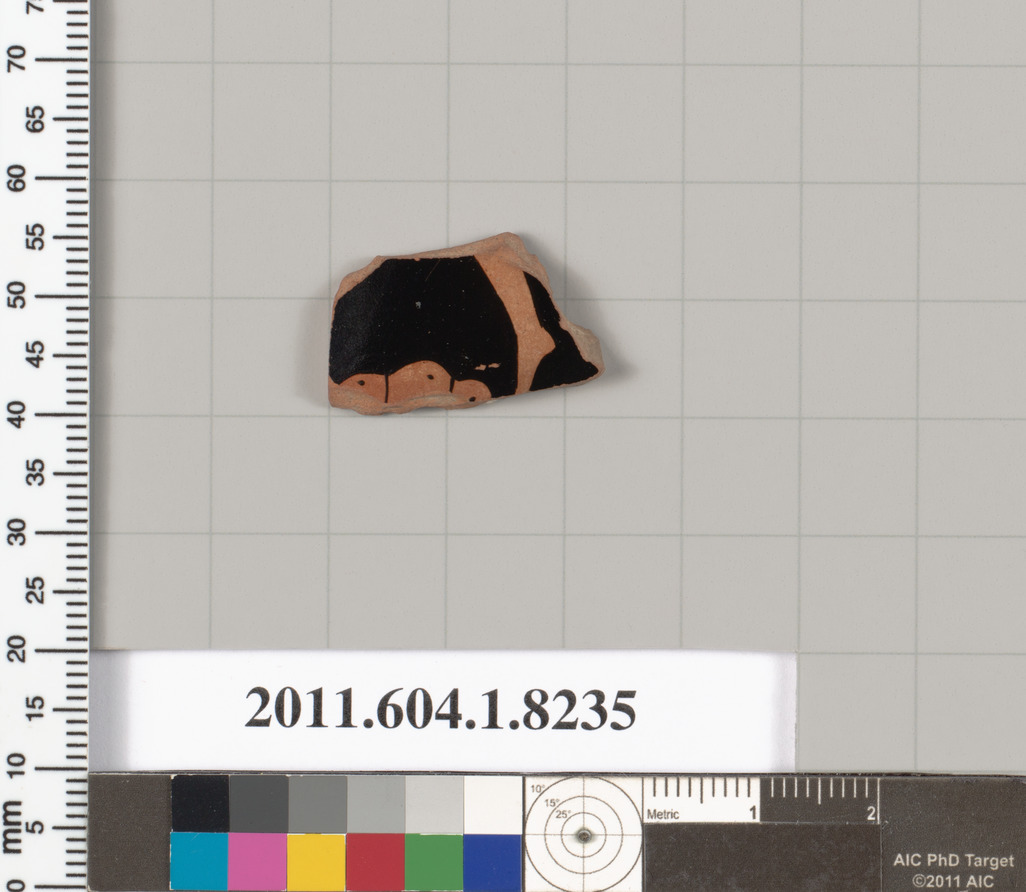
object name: kylix fragment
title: Terracotta fragment of a kylix (drinking cup)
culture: greek, attic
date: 525-515 BCE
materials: terracotta